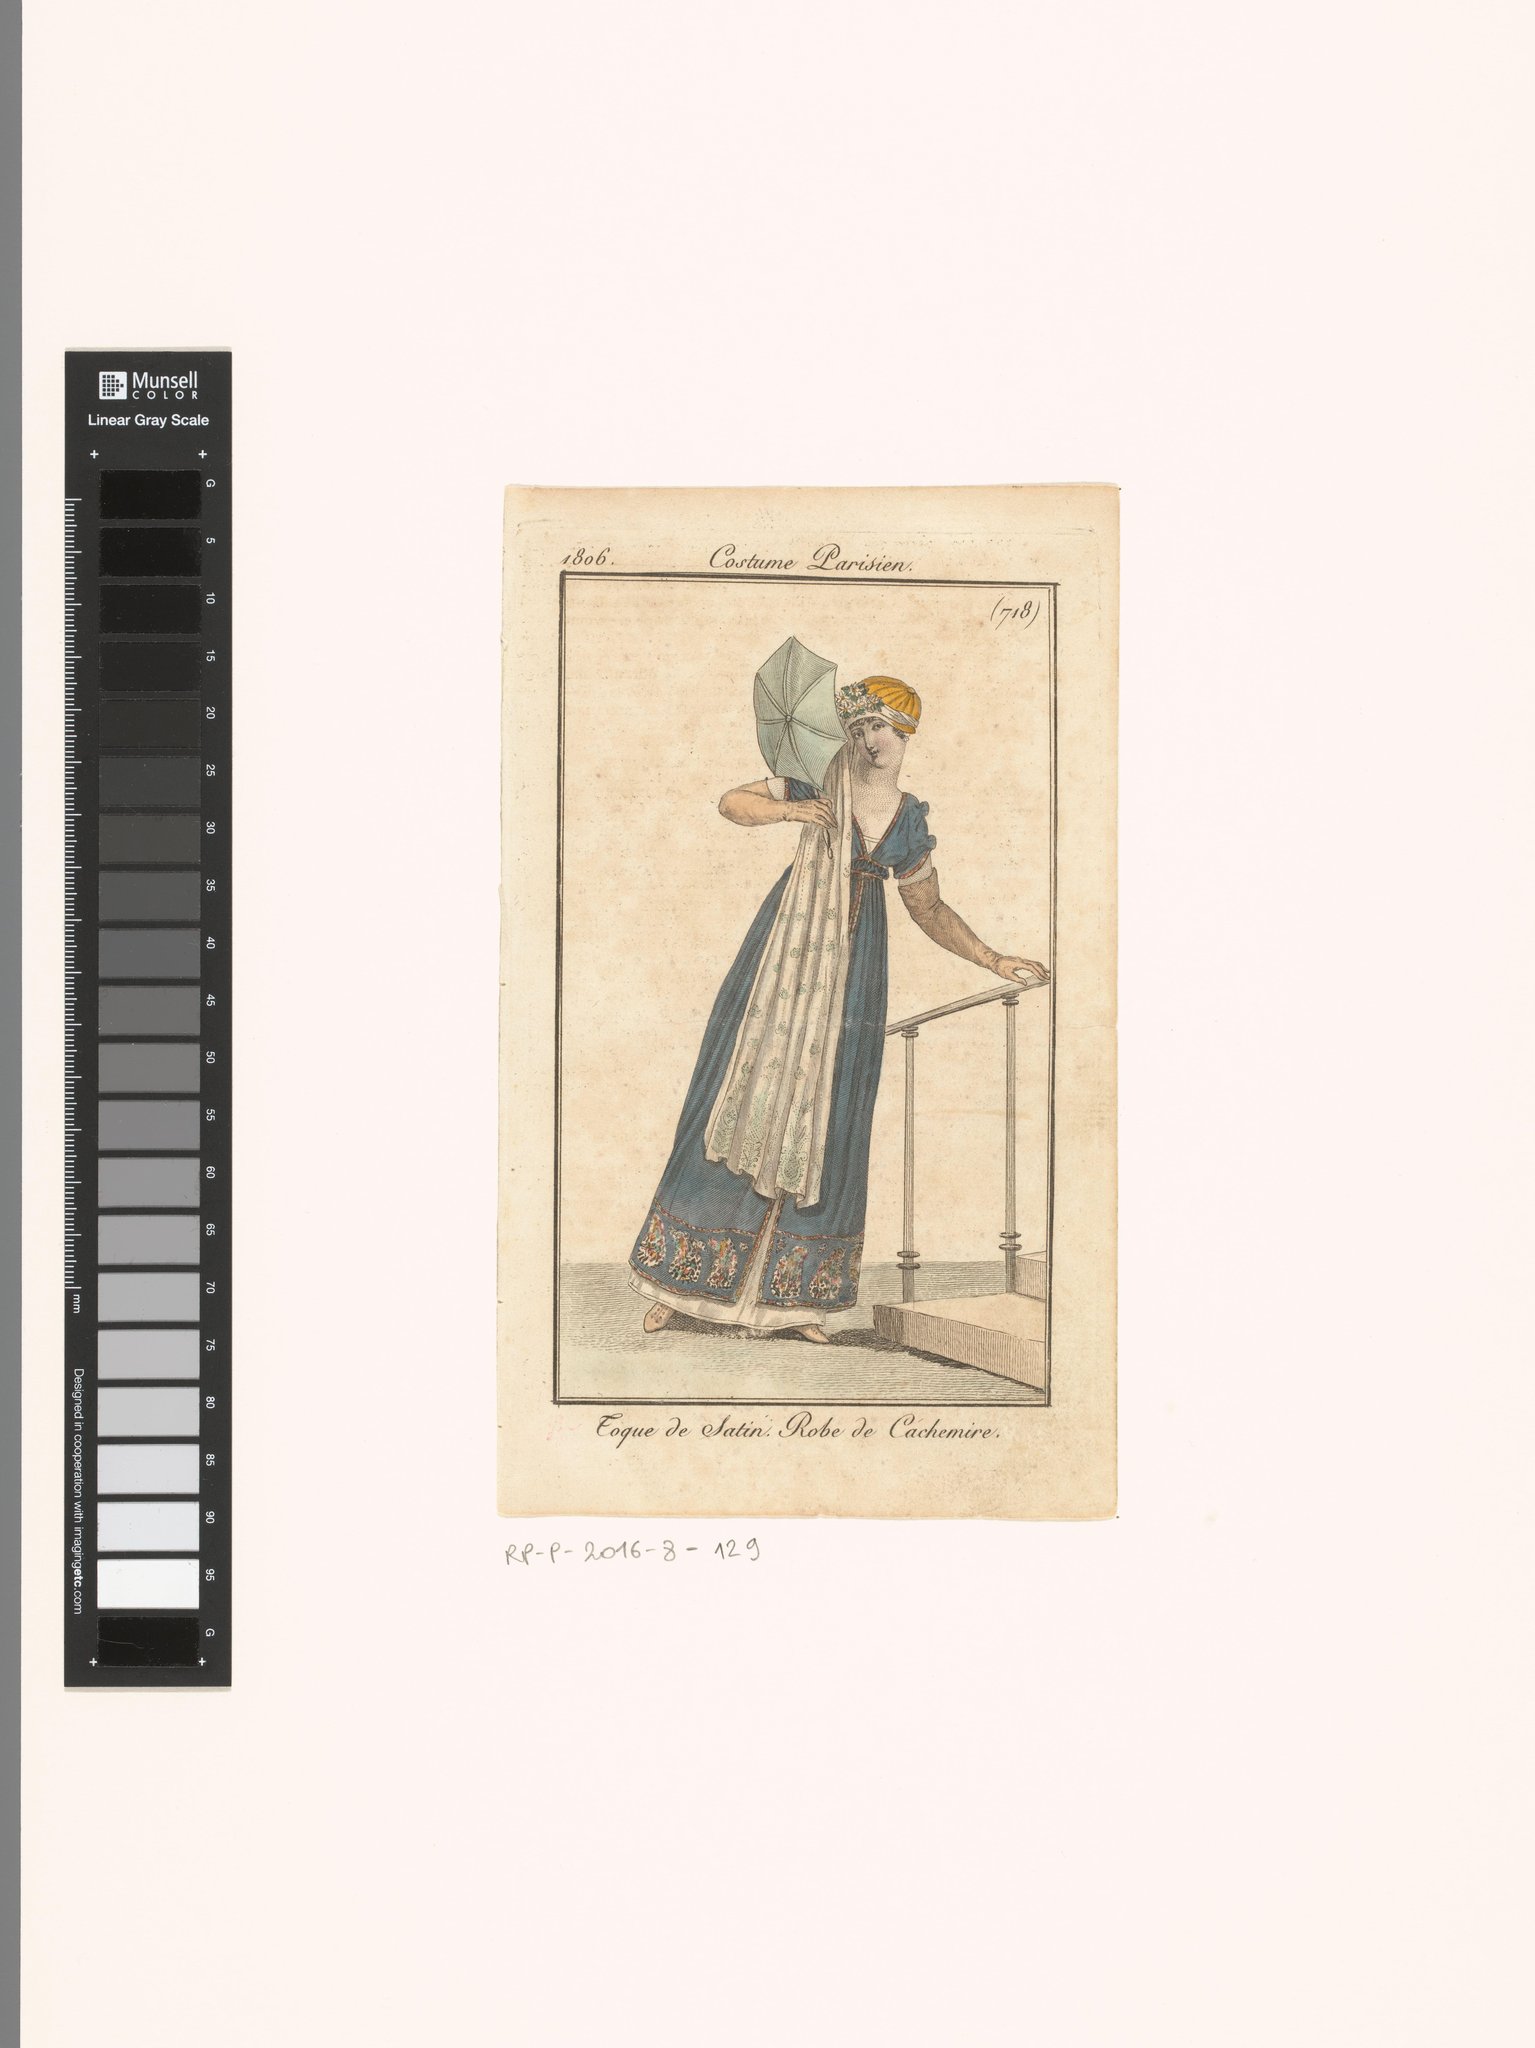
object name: fashion print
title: Journal des Dames et des modes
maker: Anonymous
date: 1806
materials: paper, ink, watercolor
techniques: etching, hand coloring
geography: france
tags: fashion plates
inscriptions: collector's mark: Lugt 2228